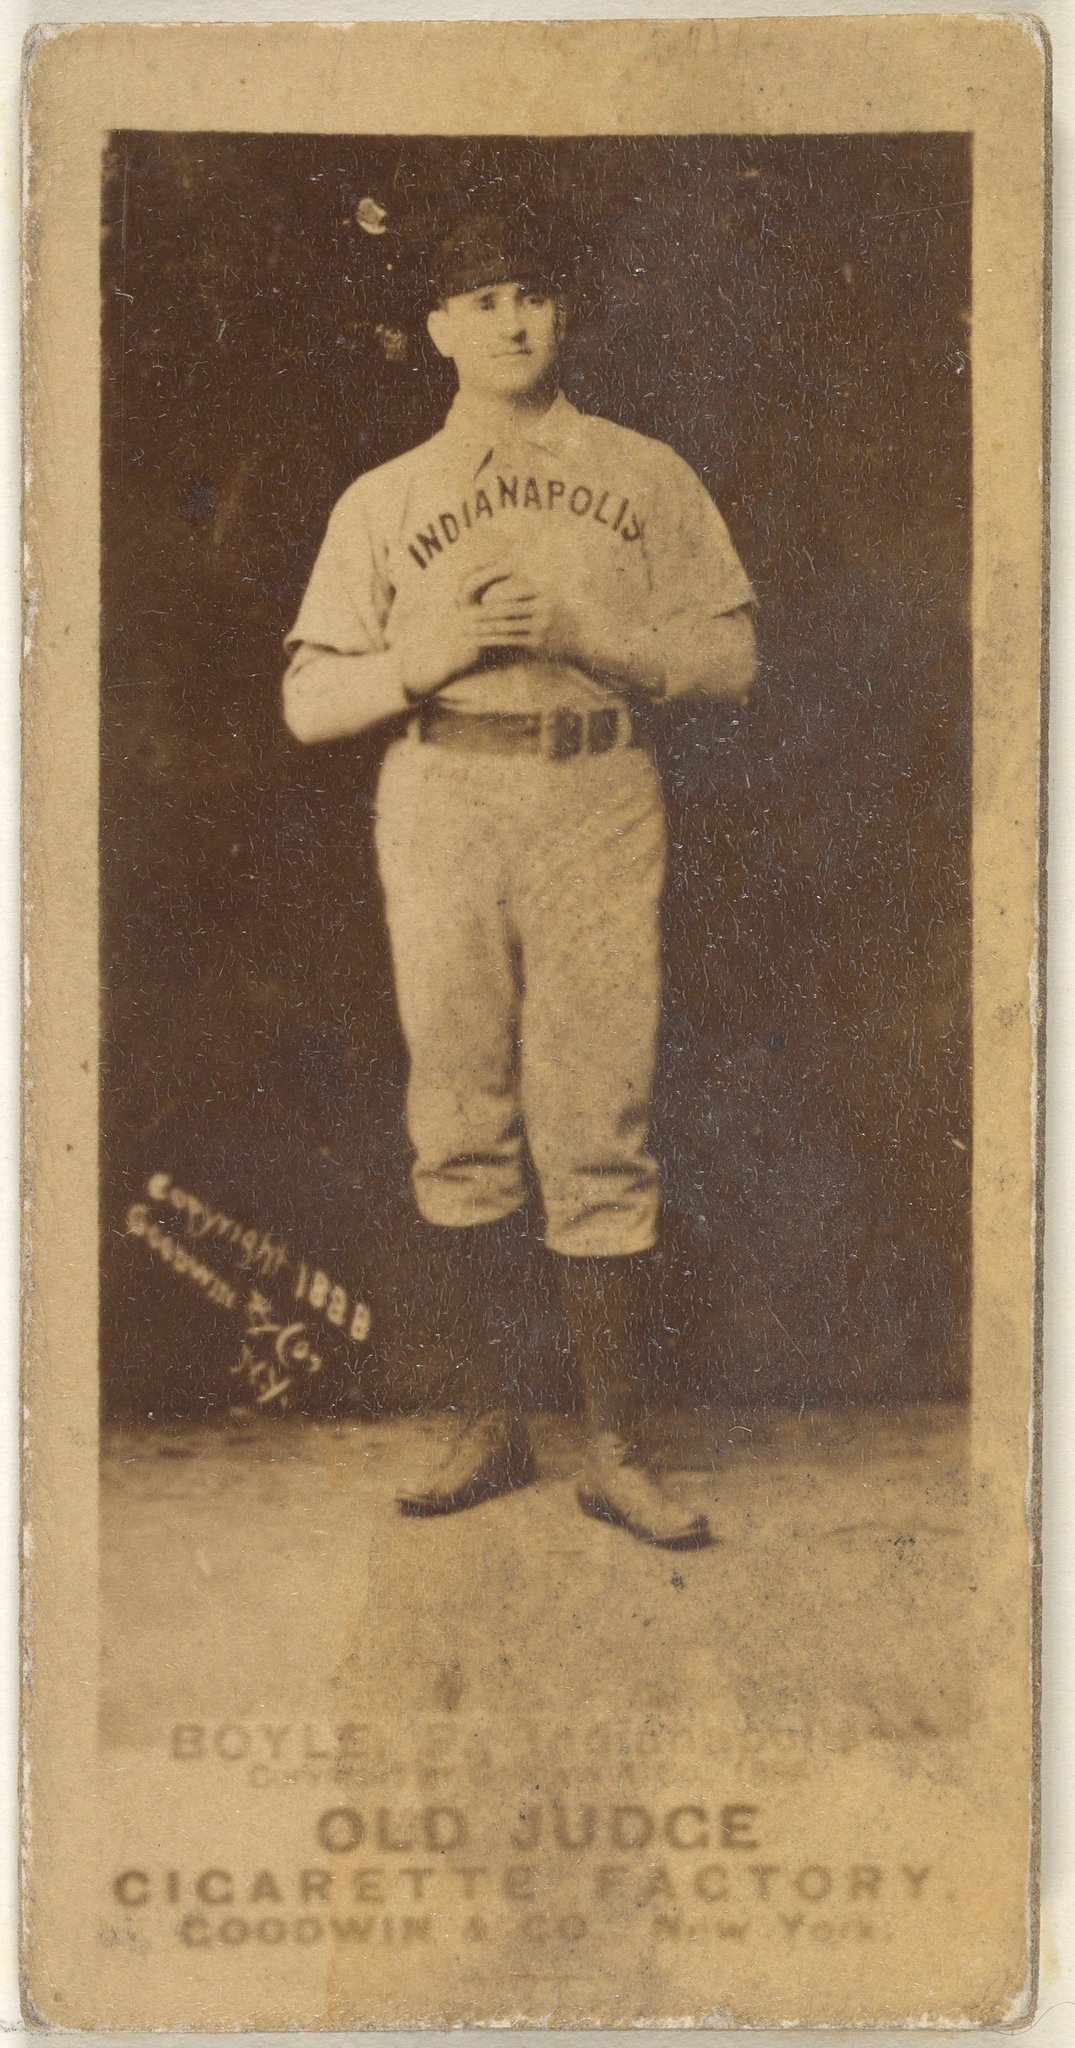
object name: baseball card, photograph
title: Boyle, Pitcher, Indianapolis, from the Old Judge series (N172) for Old Judge Cigarettes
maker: goodwin & company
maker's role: publisher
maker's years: 1850-1950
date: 1888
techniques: albumen silver print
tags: men,portraits,baseball,athletes